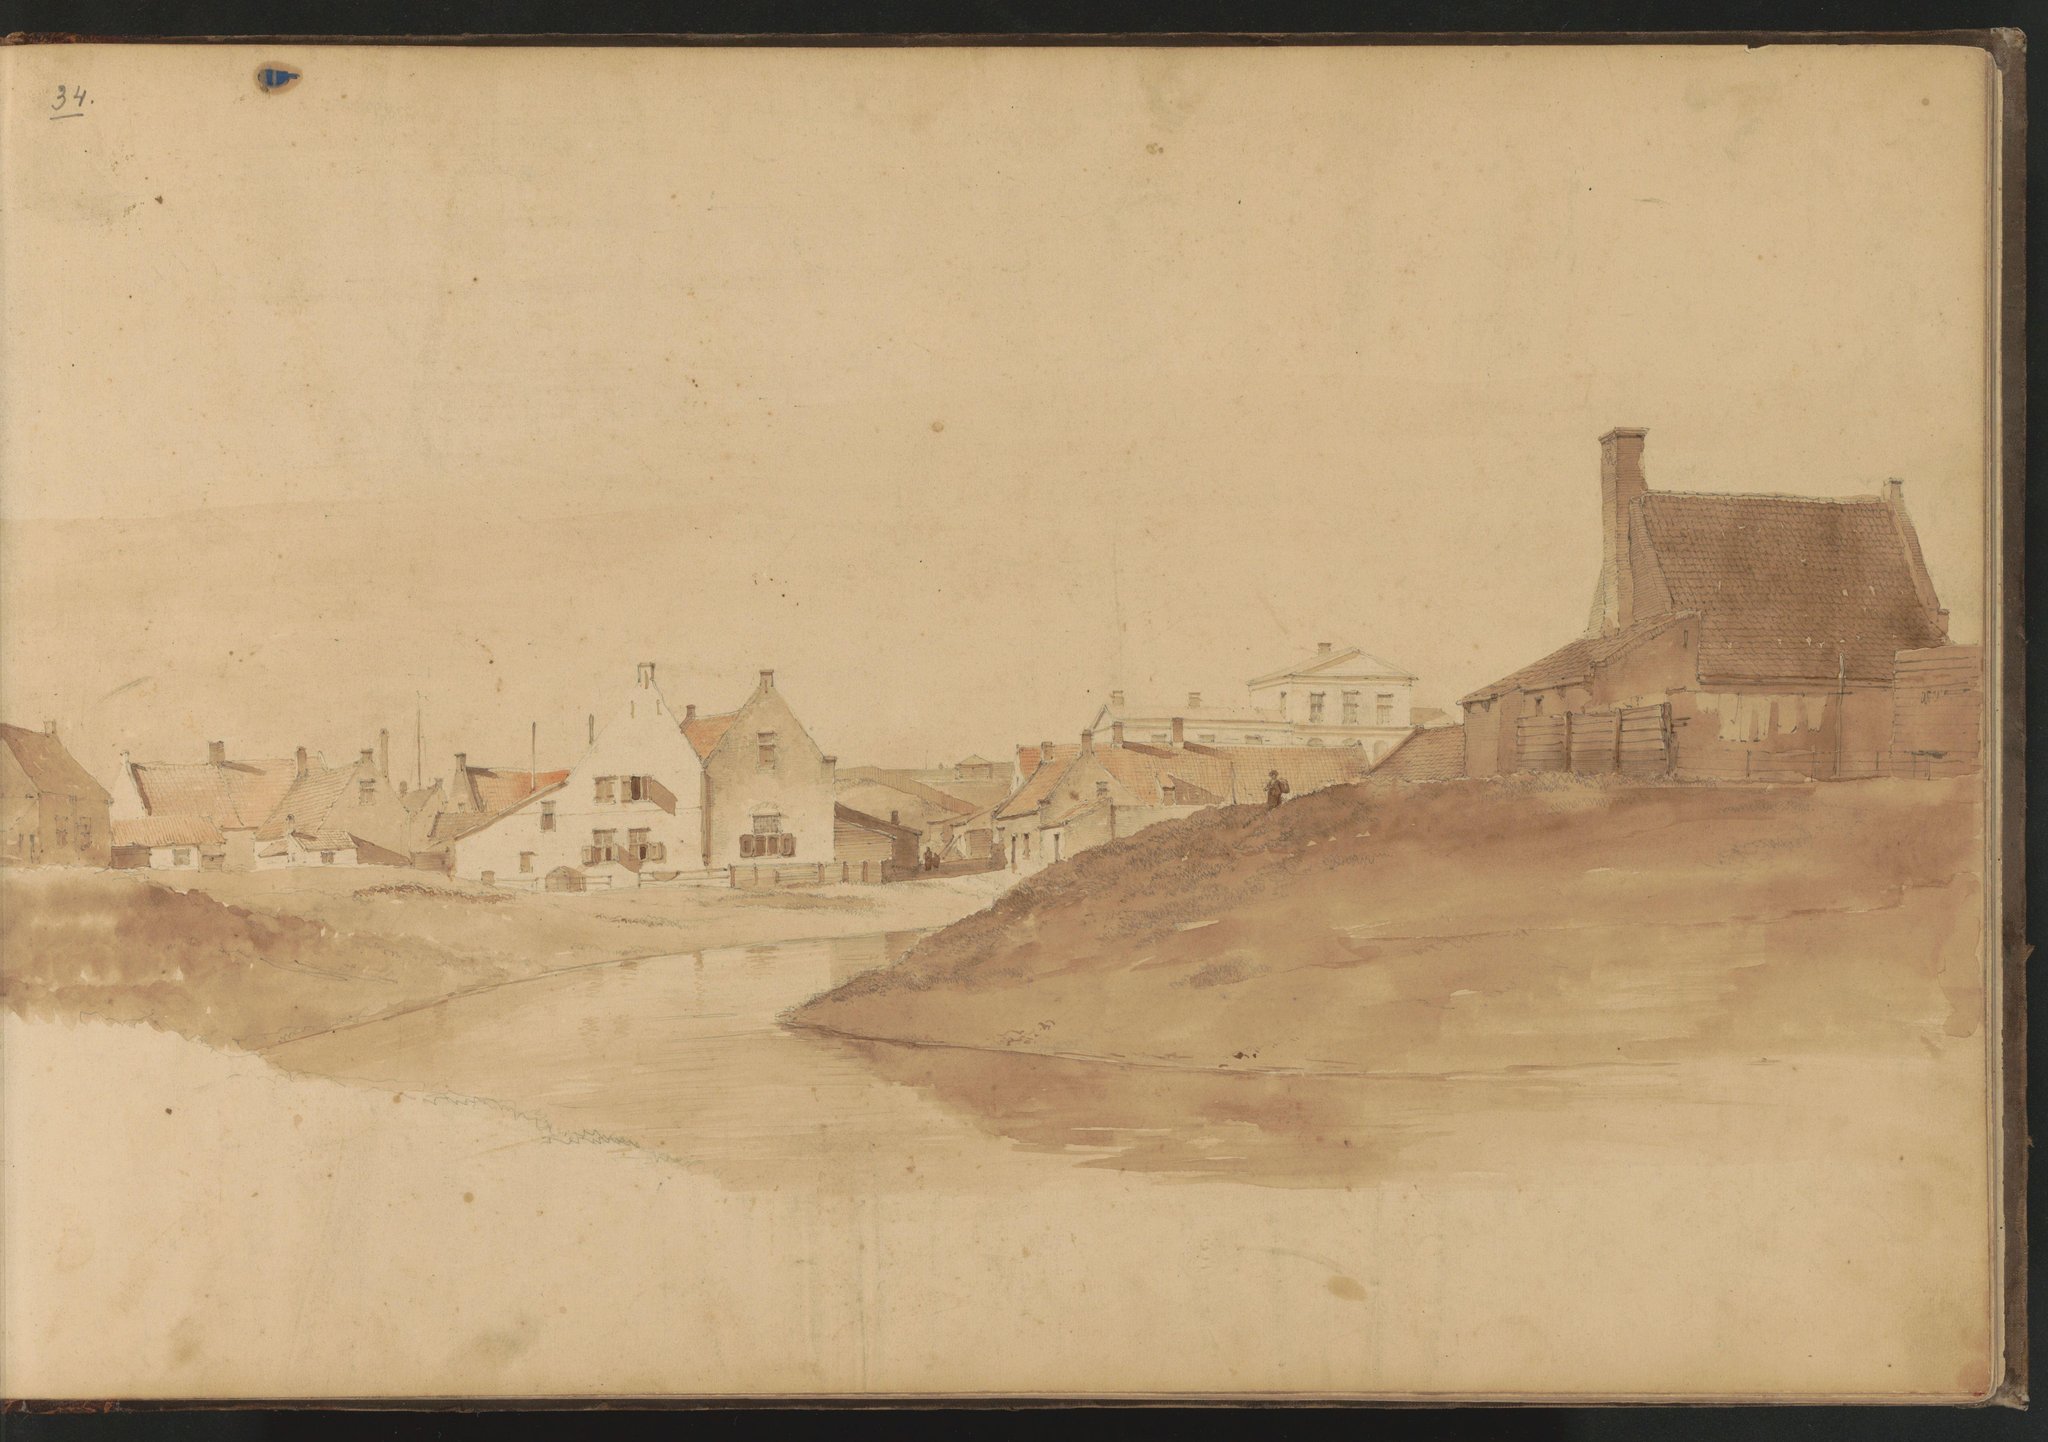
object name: sketchbook leaf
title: Huizen te Scheveningen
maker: kasparus karsen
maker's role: draughtsman, painter, print maker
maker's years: 1810-1896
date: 1820-1896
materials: paper, pencil, watercolor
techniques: brush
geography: scheveningen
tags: landscapes with waters, waterscapes, seascapes (in the temperate zone), village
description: Blad 34 recto uit een schetsboek met 68 bladen.